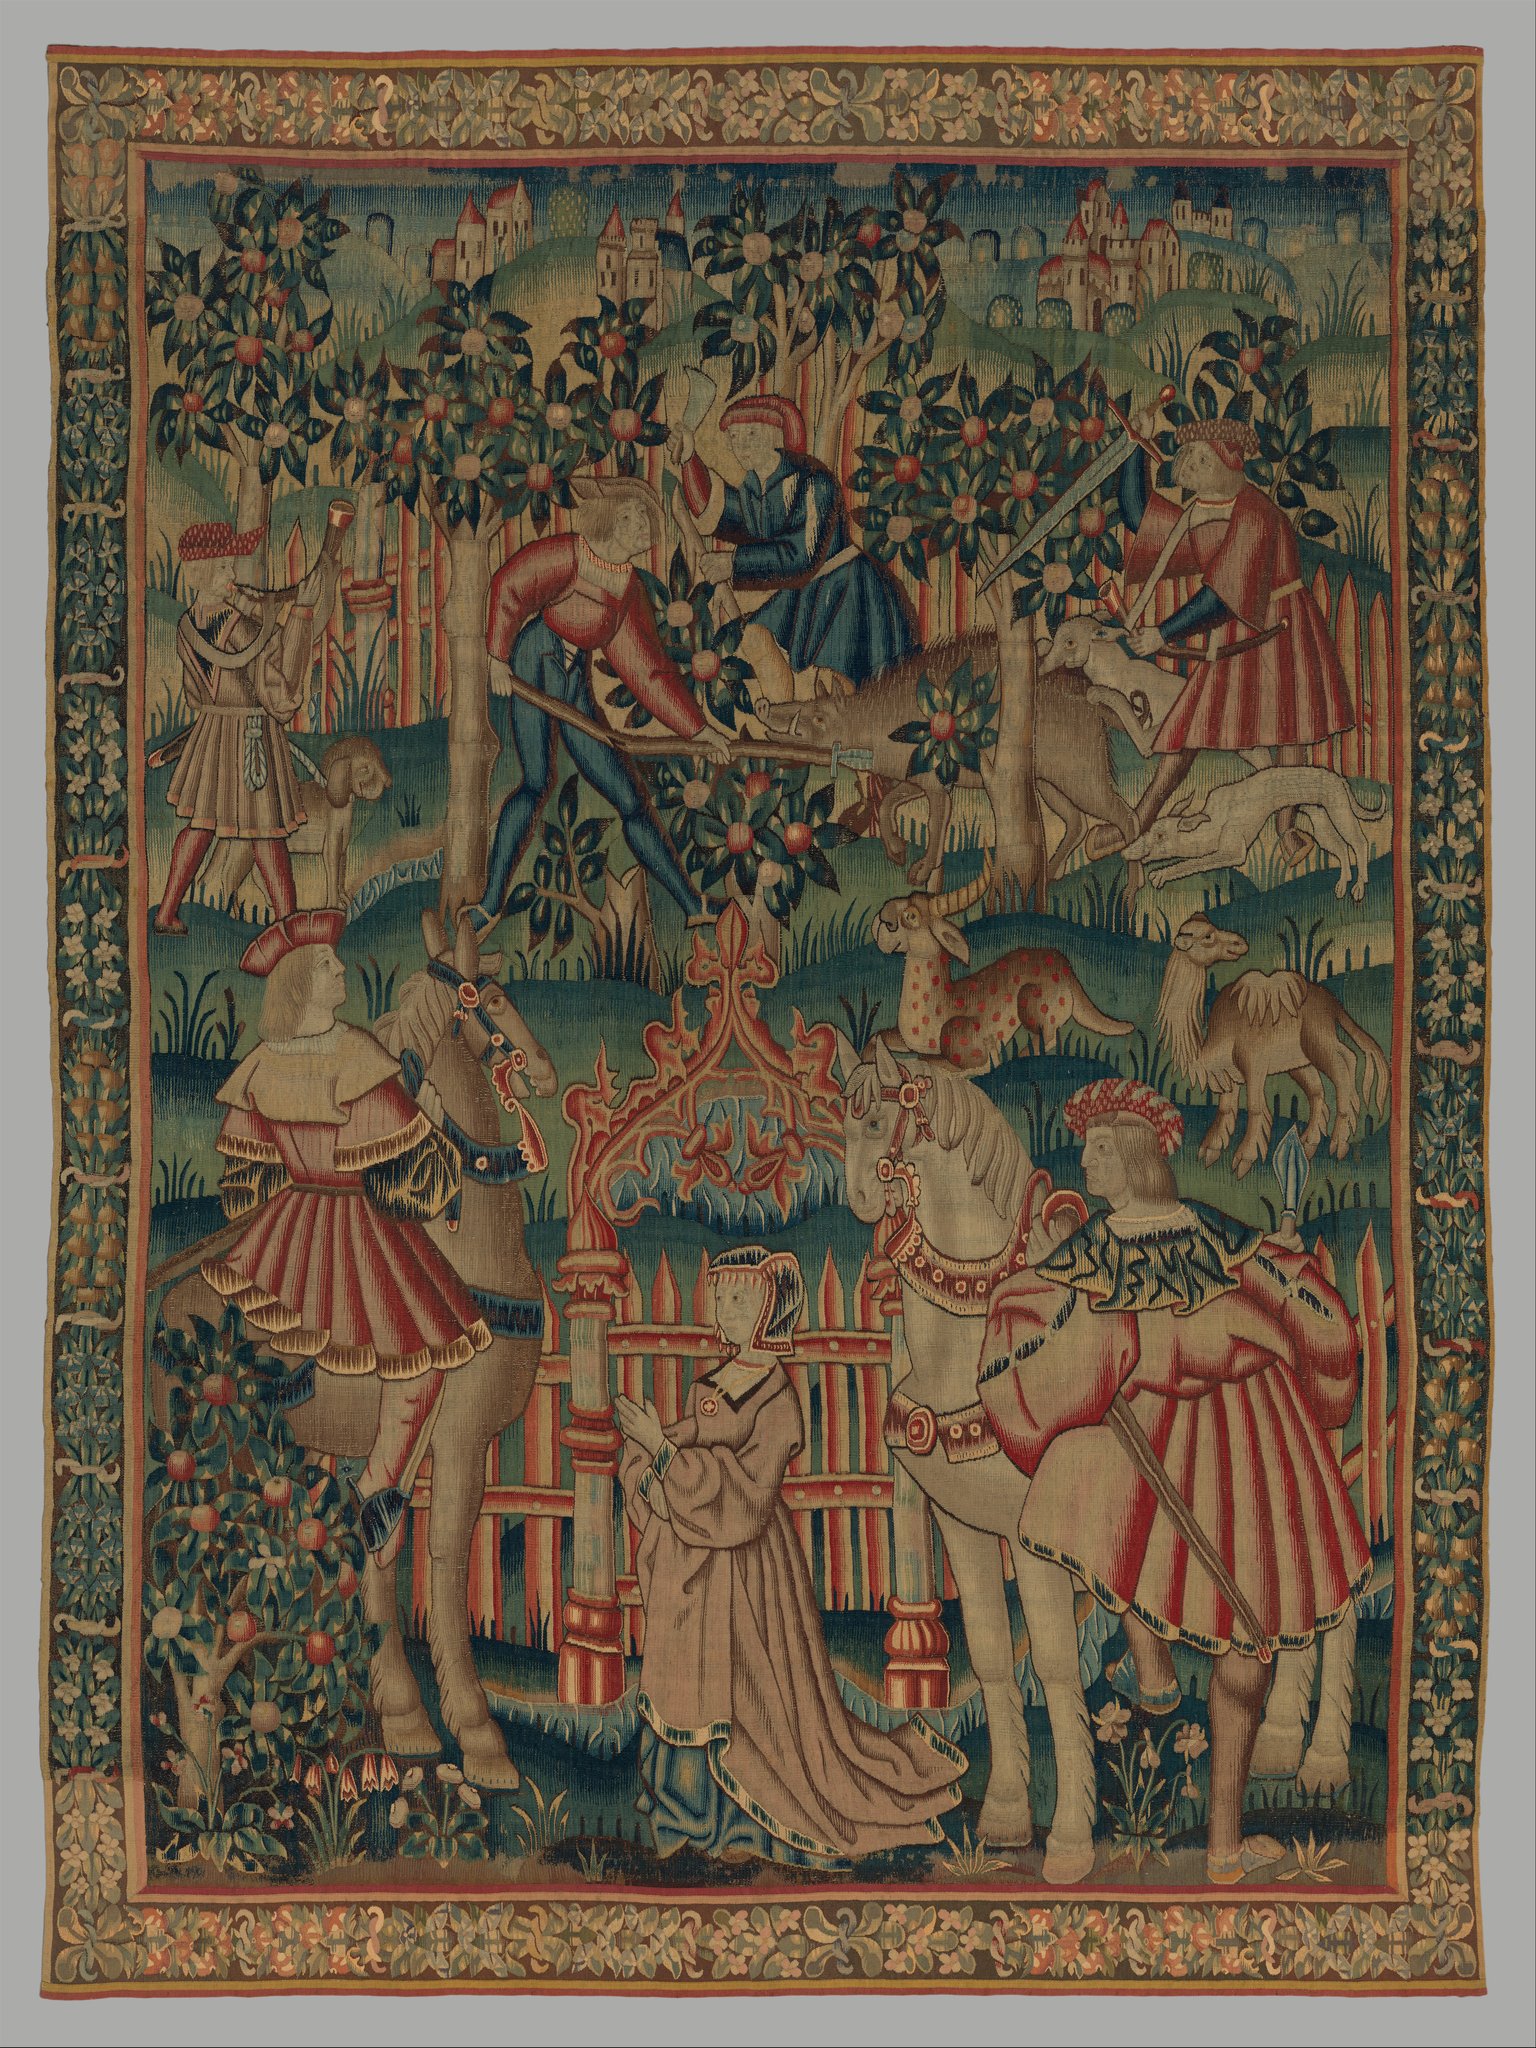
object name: tapestry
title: Hunting for Wild Boar (from the Hunting Parks Tapestries)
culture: south netherlandish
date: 1515-1535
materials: thread, wool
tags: men,hunting,boars,horses